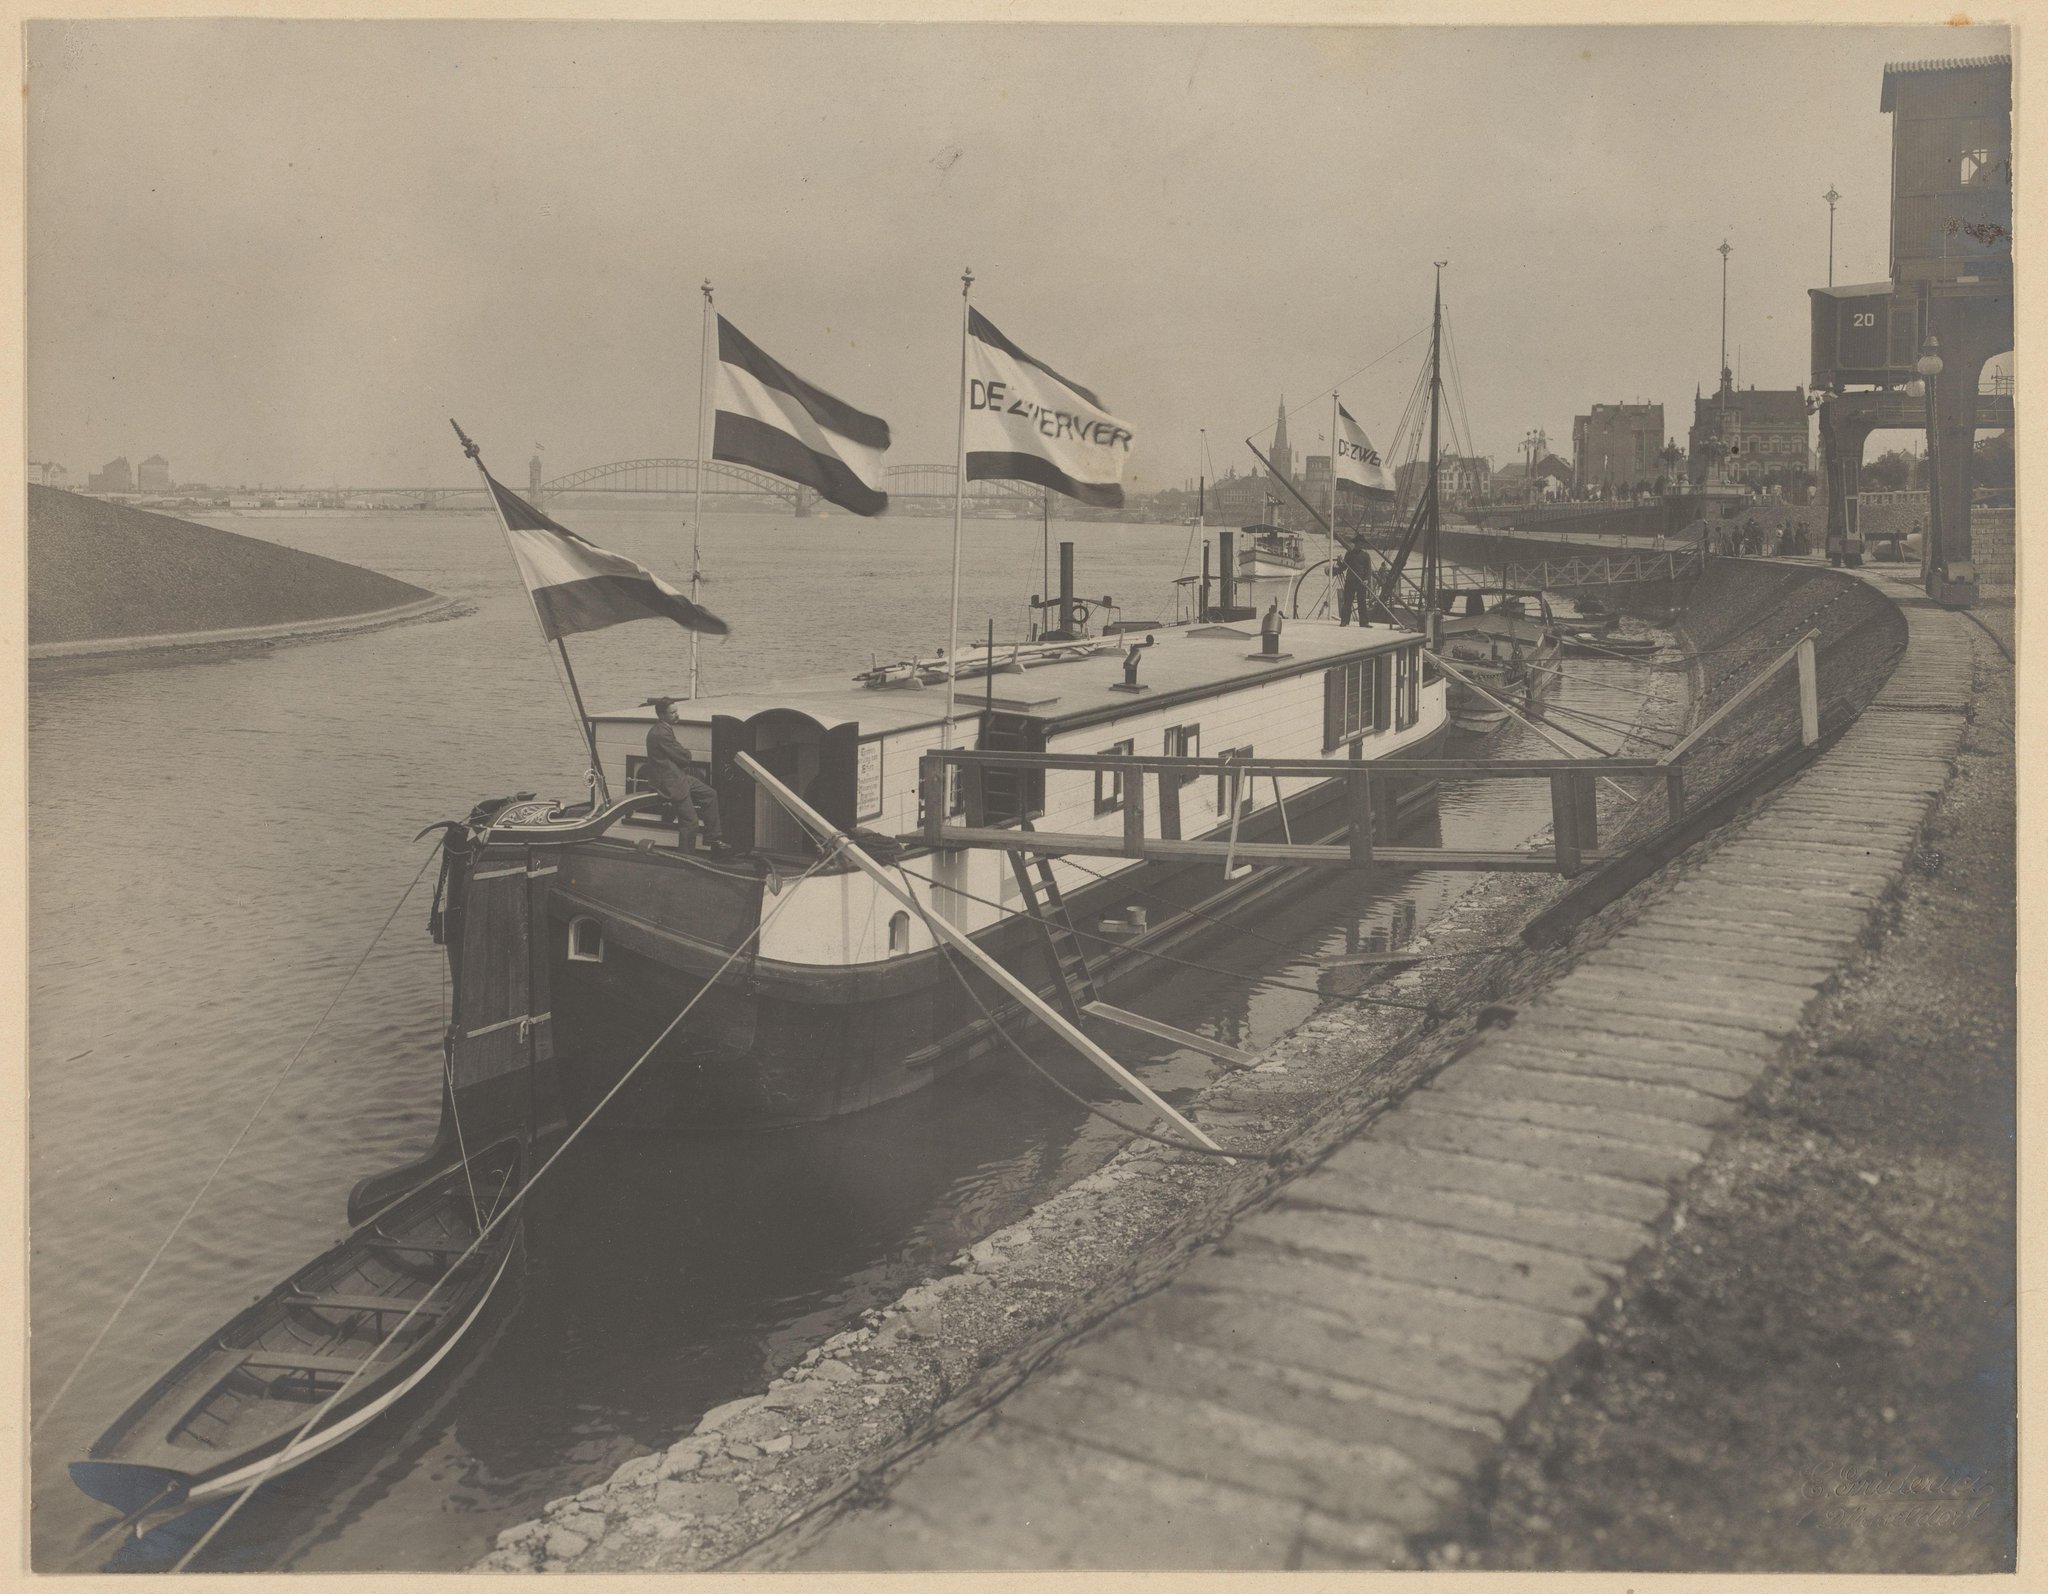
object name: photograph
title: Wijnand Otto Jan Nieuwenkamp op de achtersteven van zijn woonboot 'De Zwerver'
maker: emil friderici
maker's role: fotograaf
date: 1902-1910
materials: cardboard, paper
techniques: gelatin silver print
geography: dusseldorf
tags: amsterdam, print maker, draughtsman, wijnand otto jan nieuwenkamp, historical persons, ships (in general)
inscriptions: collector's mark: Lugt 2233